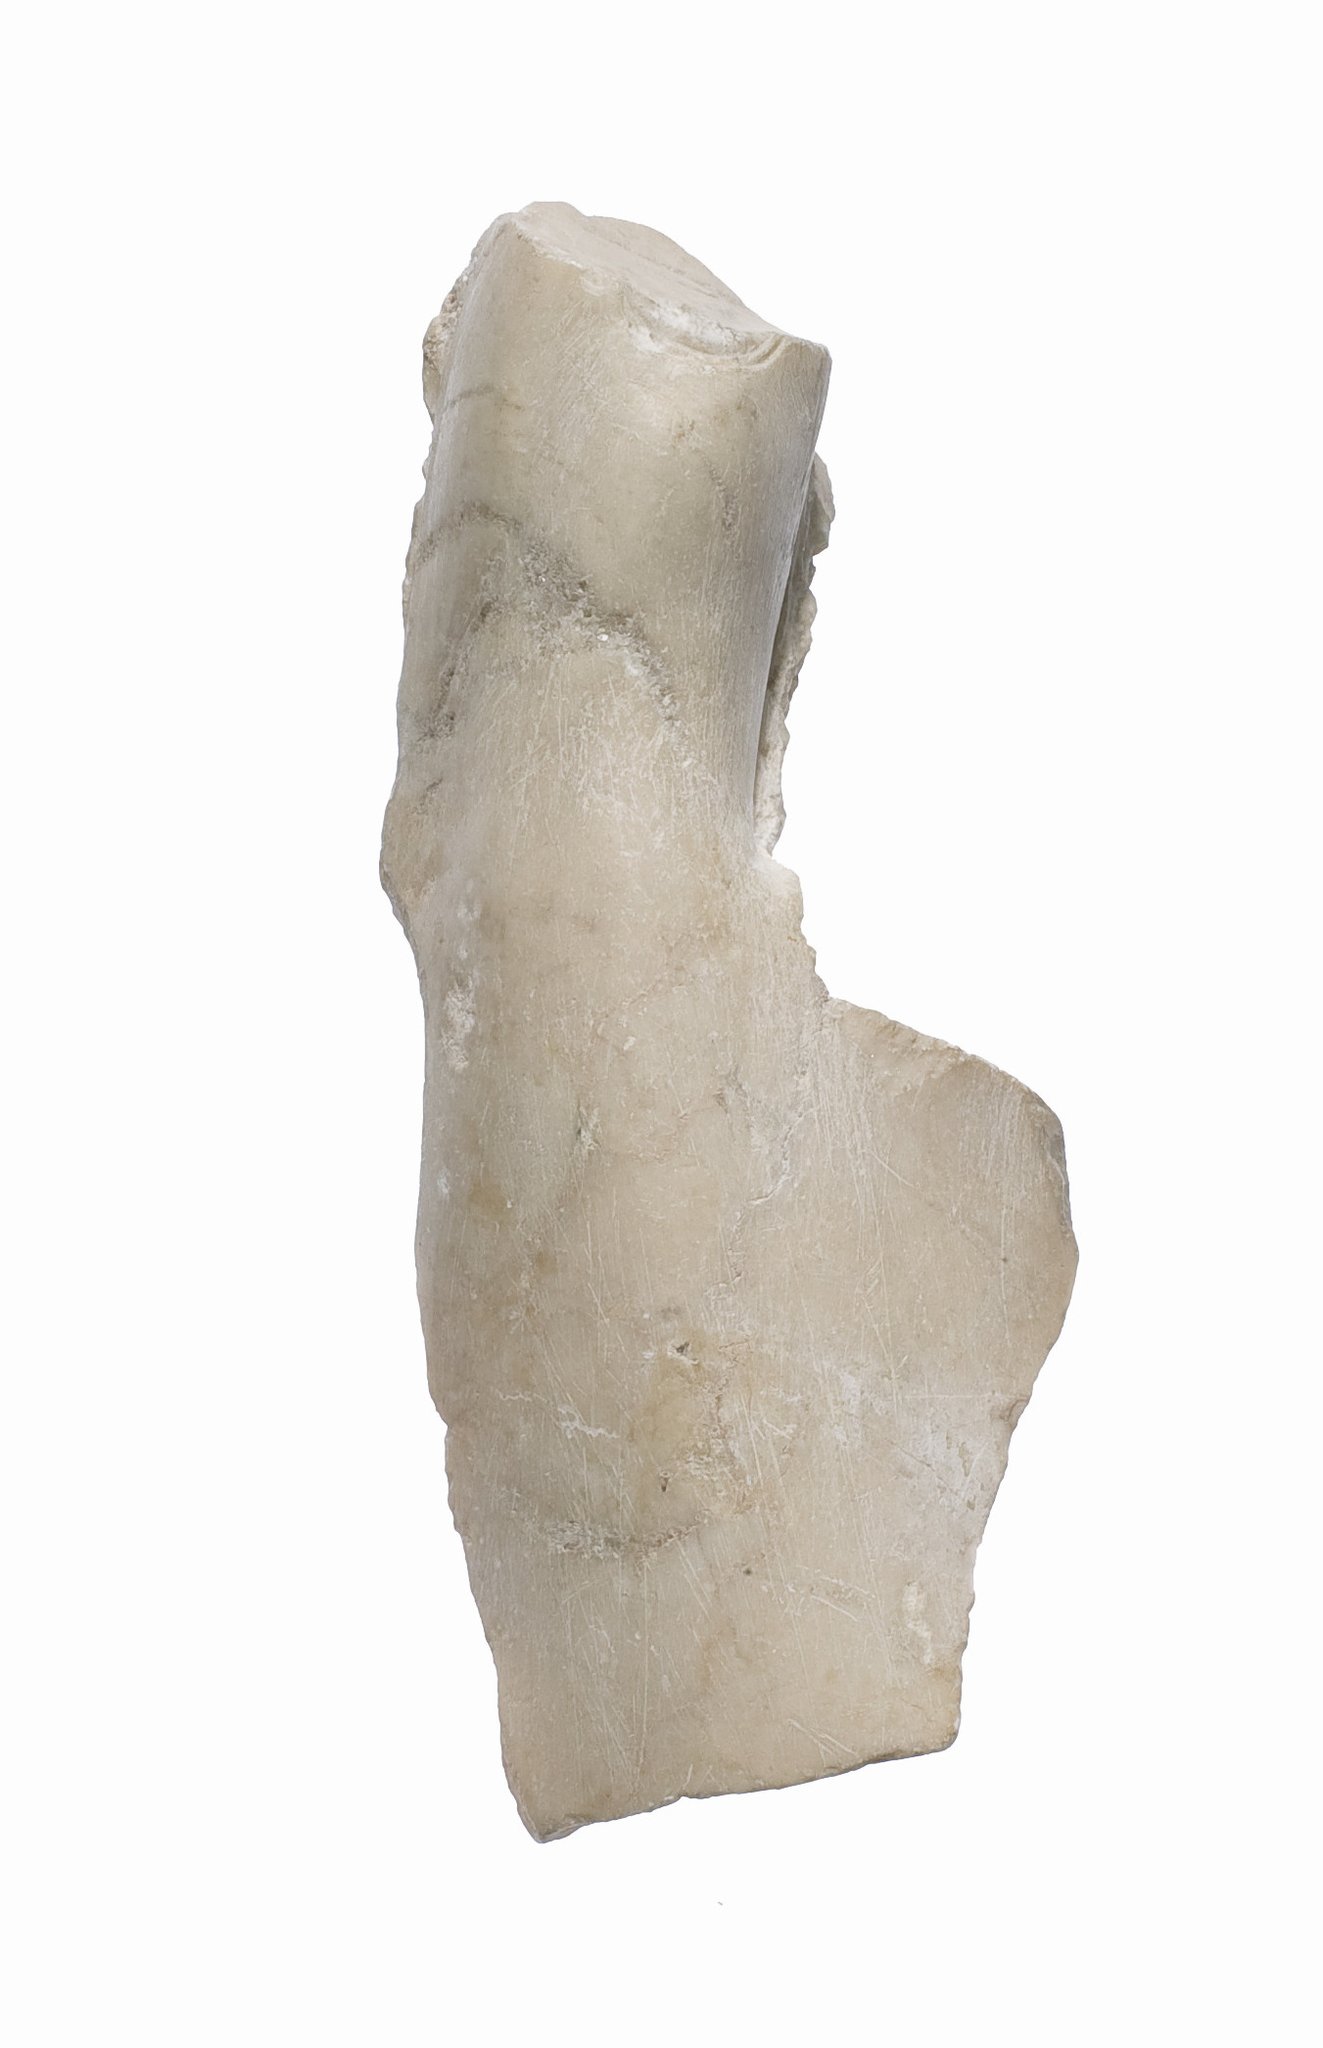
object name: digit fragment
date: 1353-1336 BCE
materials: limestone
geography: egypt